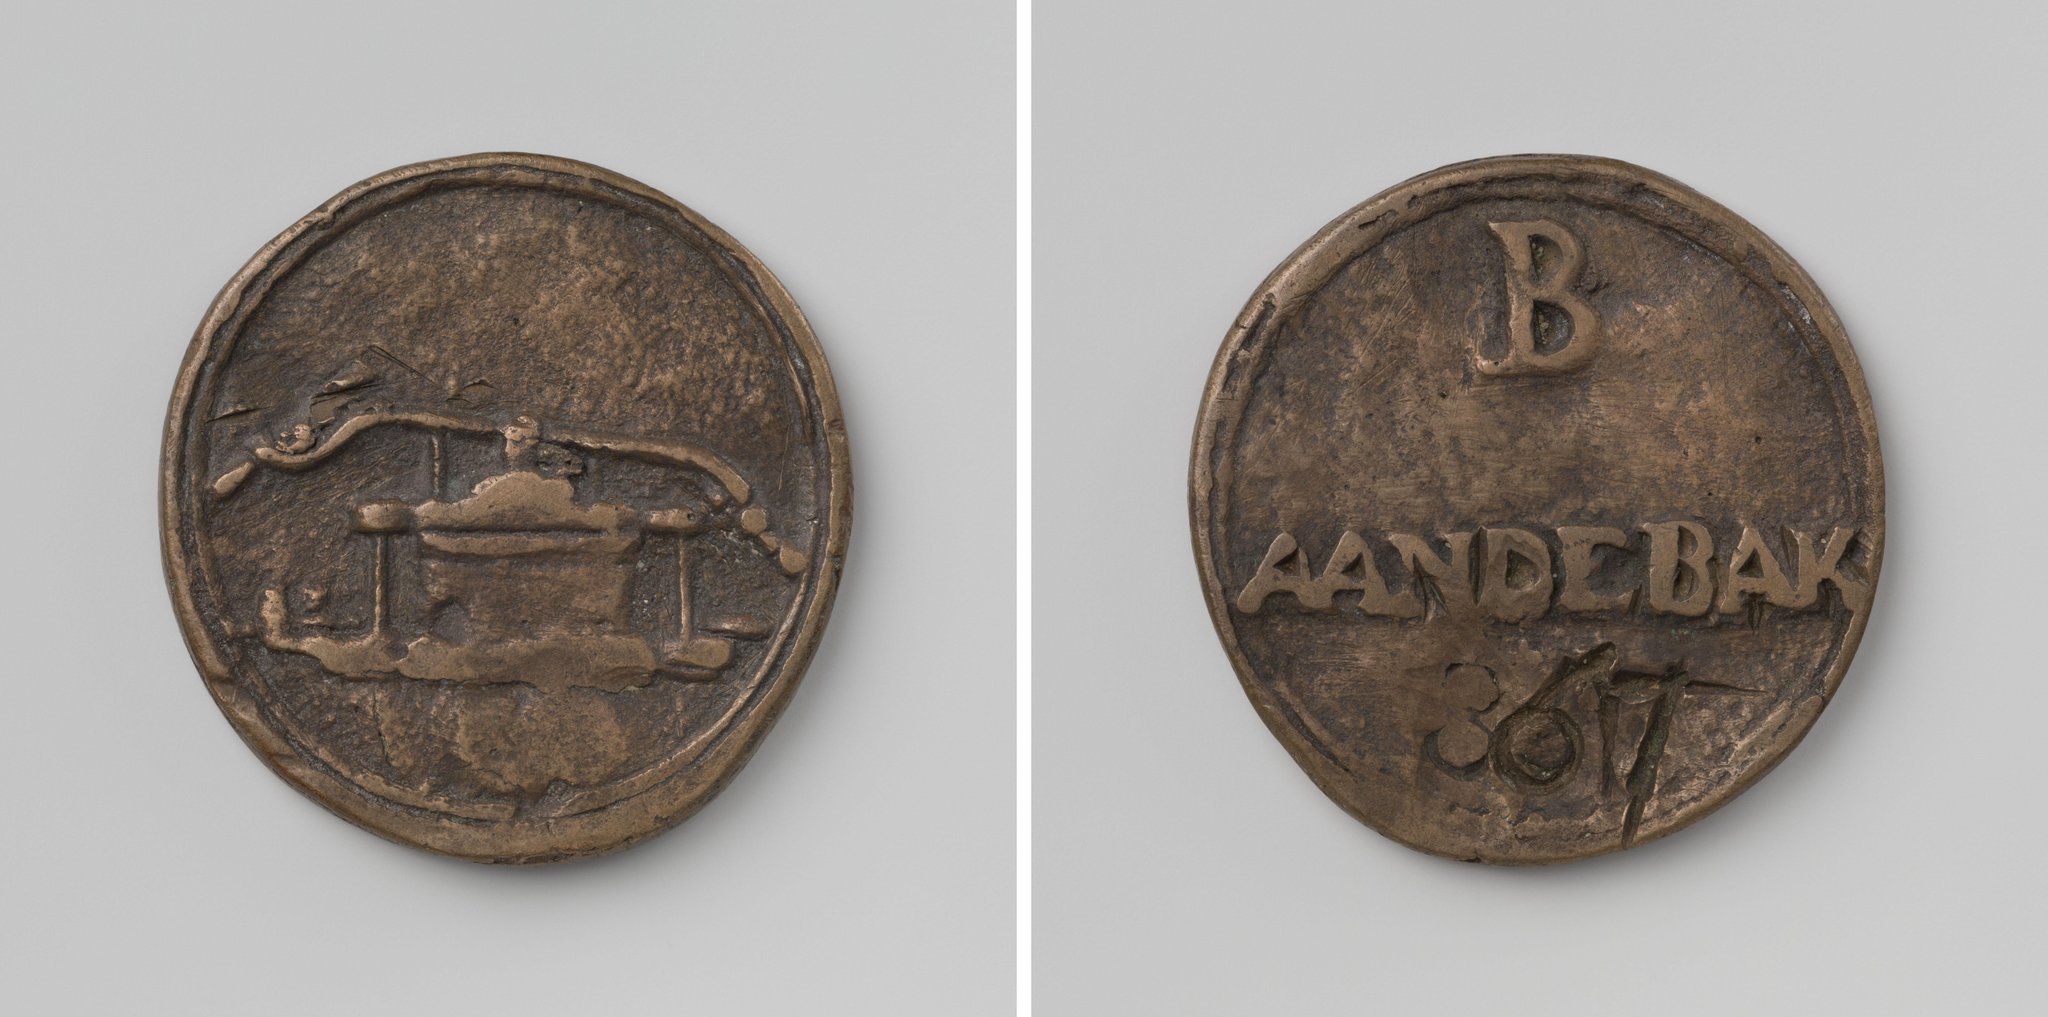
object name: fire engine medal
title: Enkhuizen, brandspuitpenning van de man aan de bak van spuit B met no. 67 en no. 3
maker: Anonymous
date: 1680-1800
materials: brass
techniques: casting, engraving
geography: enkhuizen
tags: enkhuizen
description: Messing penning. Voorzijde: brandspuit. Keerzijde: opschrift boven cijfer 67, gekrast over cijfer dat met 3 begint